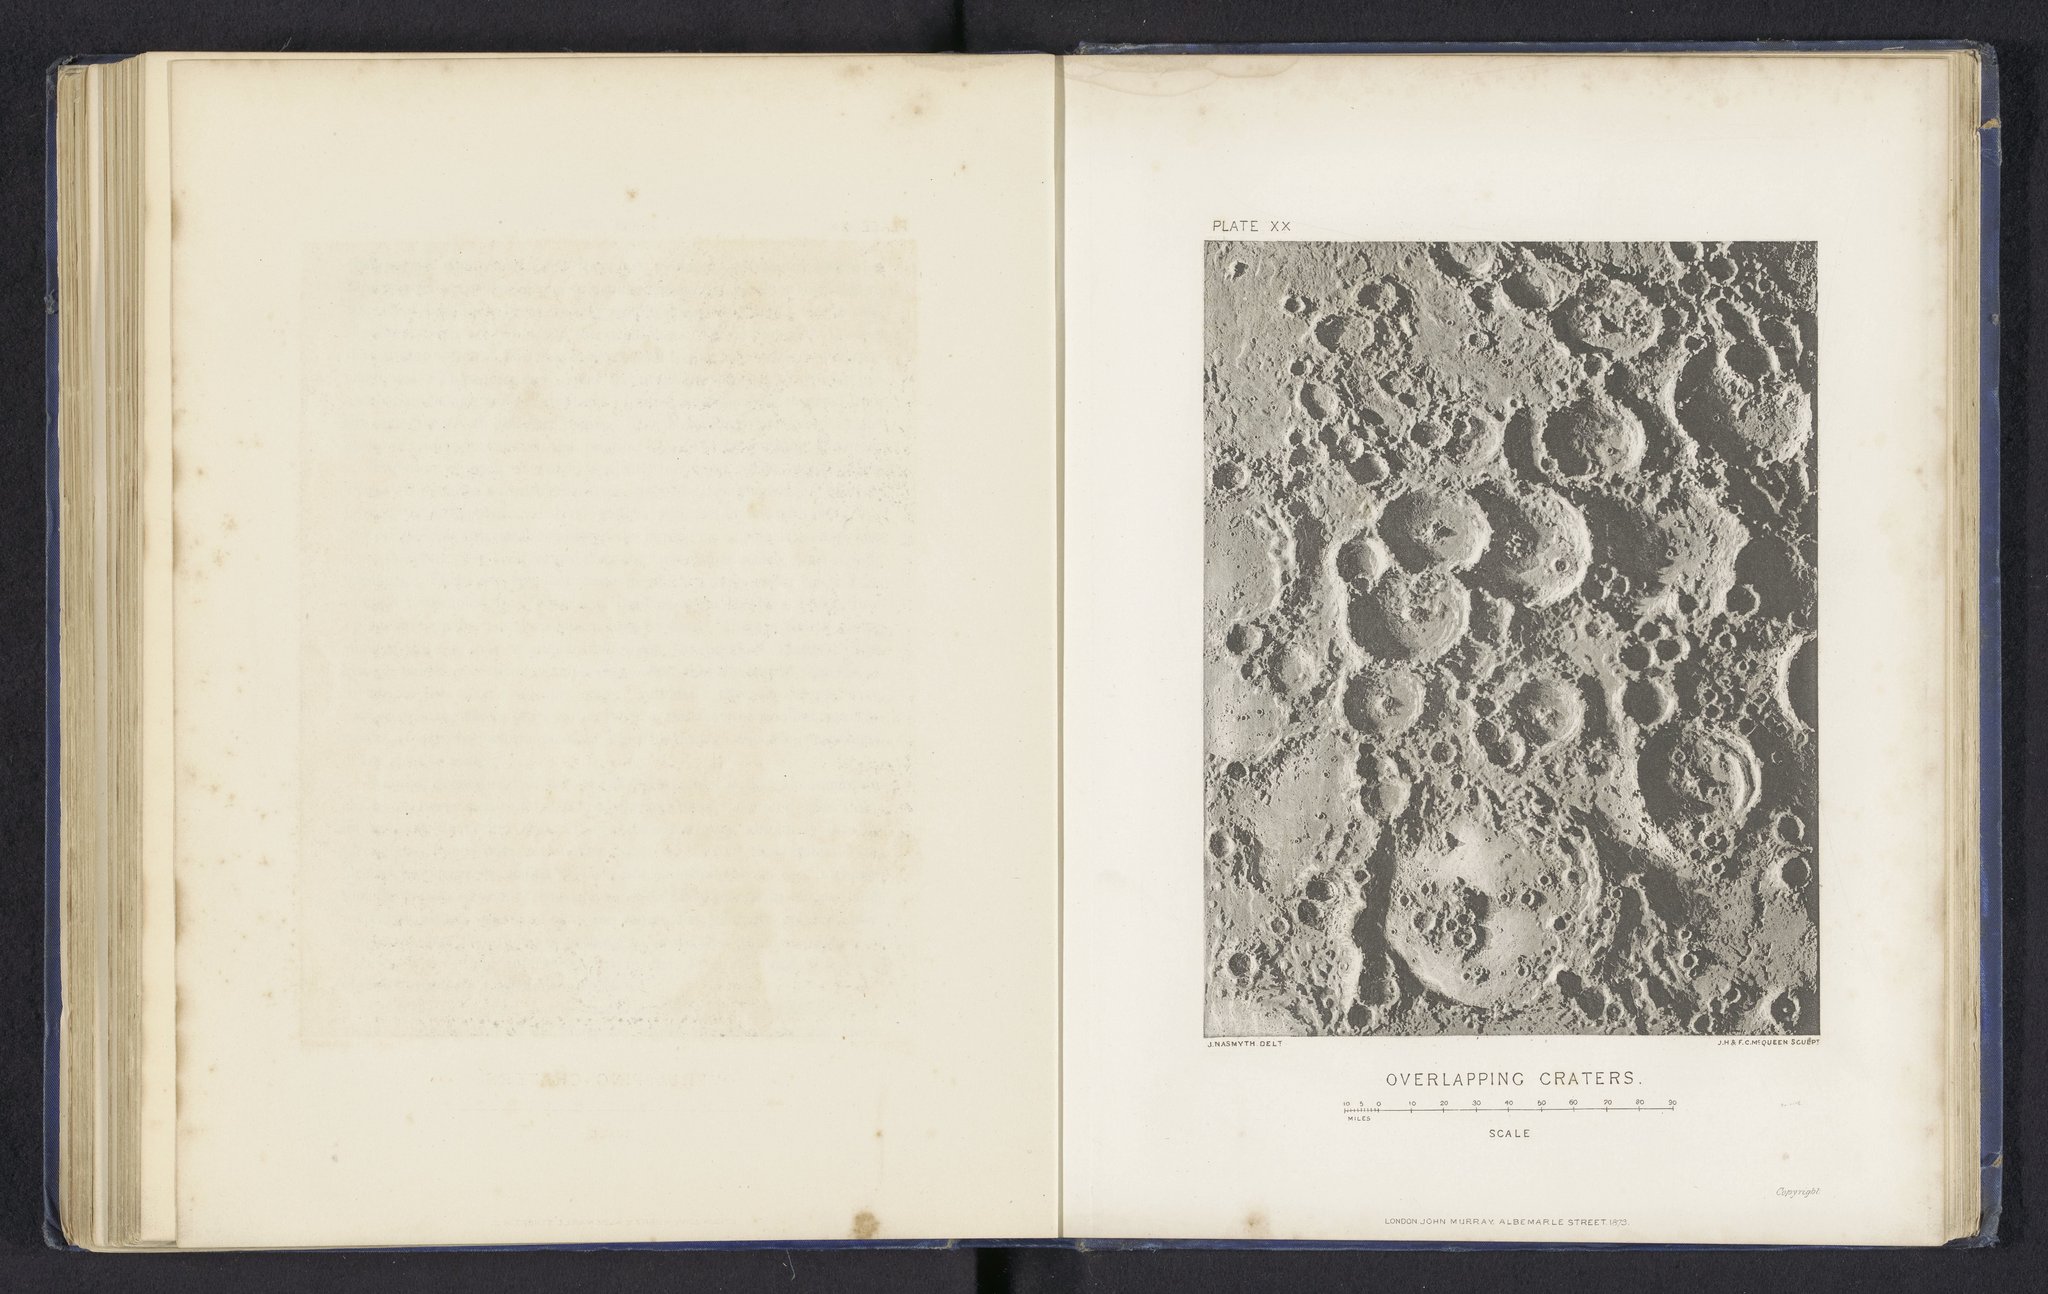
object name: print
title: Overlapping craters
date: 1873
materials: paper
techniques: lithograph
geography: united kingdom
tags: surface of the moon, moon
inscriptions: number: ‘Plate XX.’, inscription: ‘Scale’, name: ‘London John Murray, Albemarle Street 1873.’